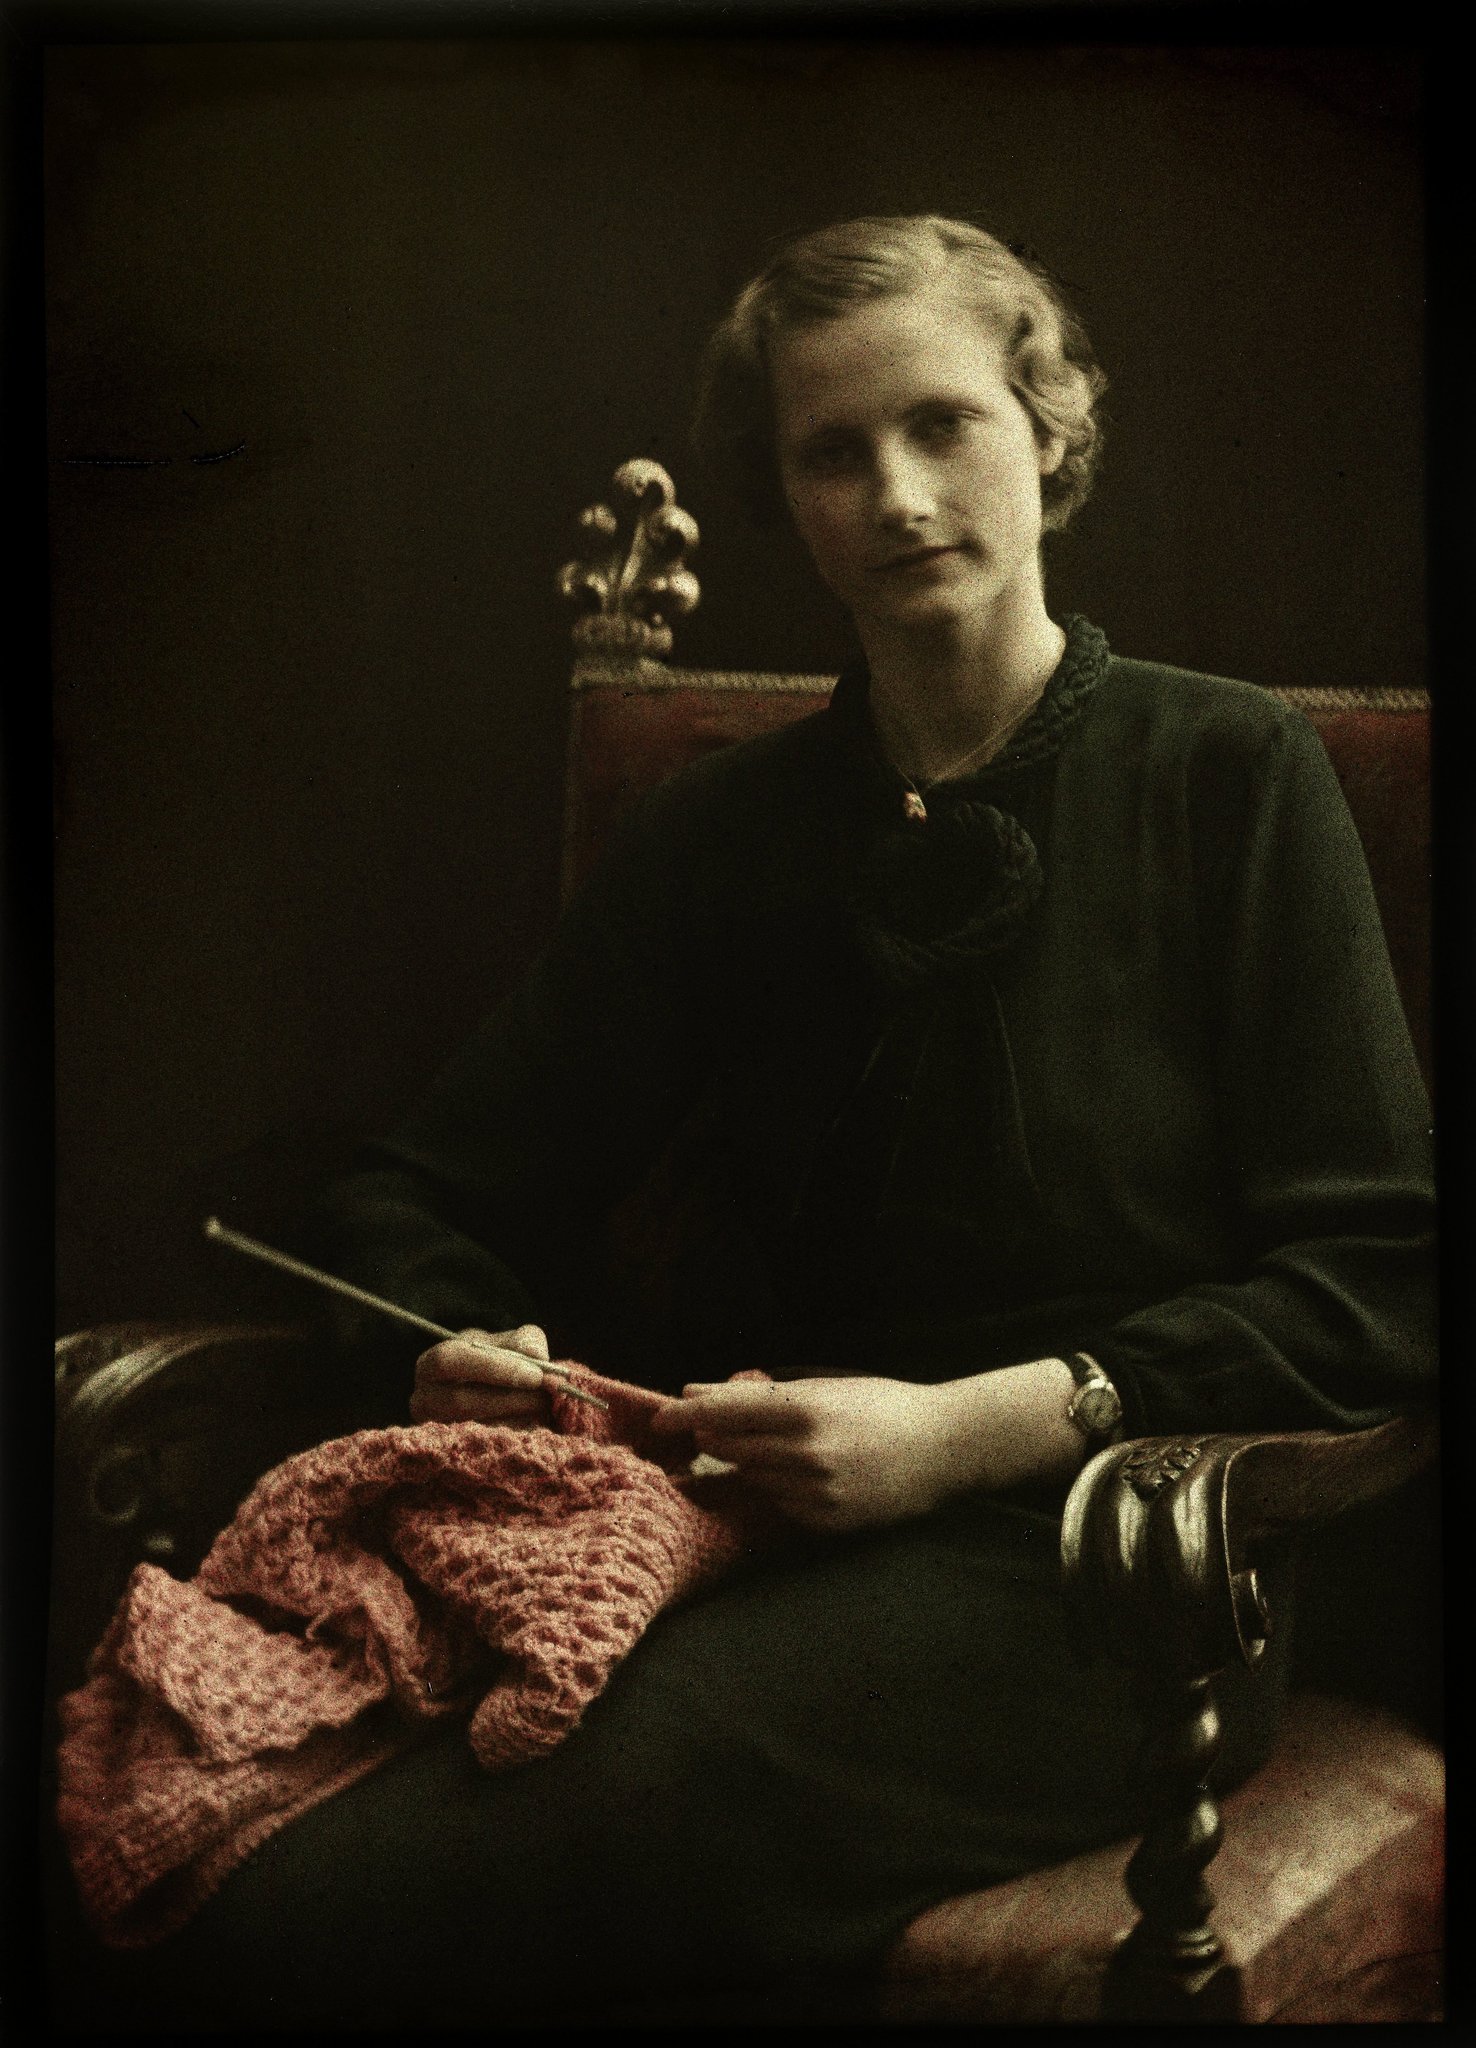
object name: glasdia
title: Portret van een vrouw, zittend in een stoel, met breiwerk in de hand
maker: Anonymous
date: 1907-1930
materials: glass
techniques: autochrome process, slide